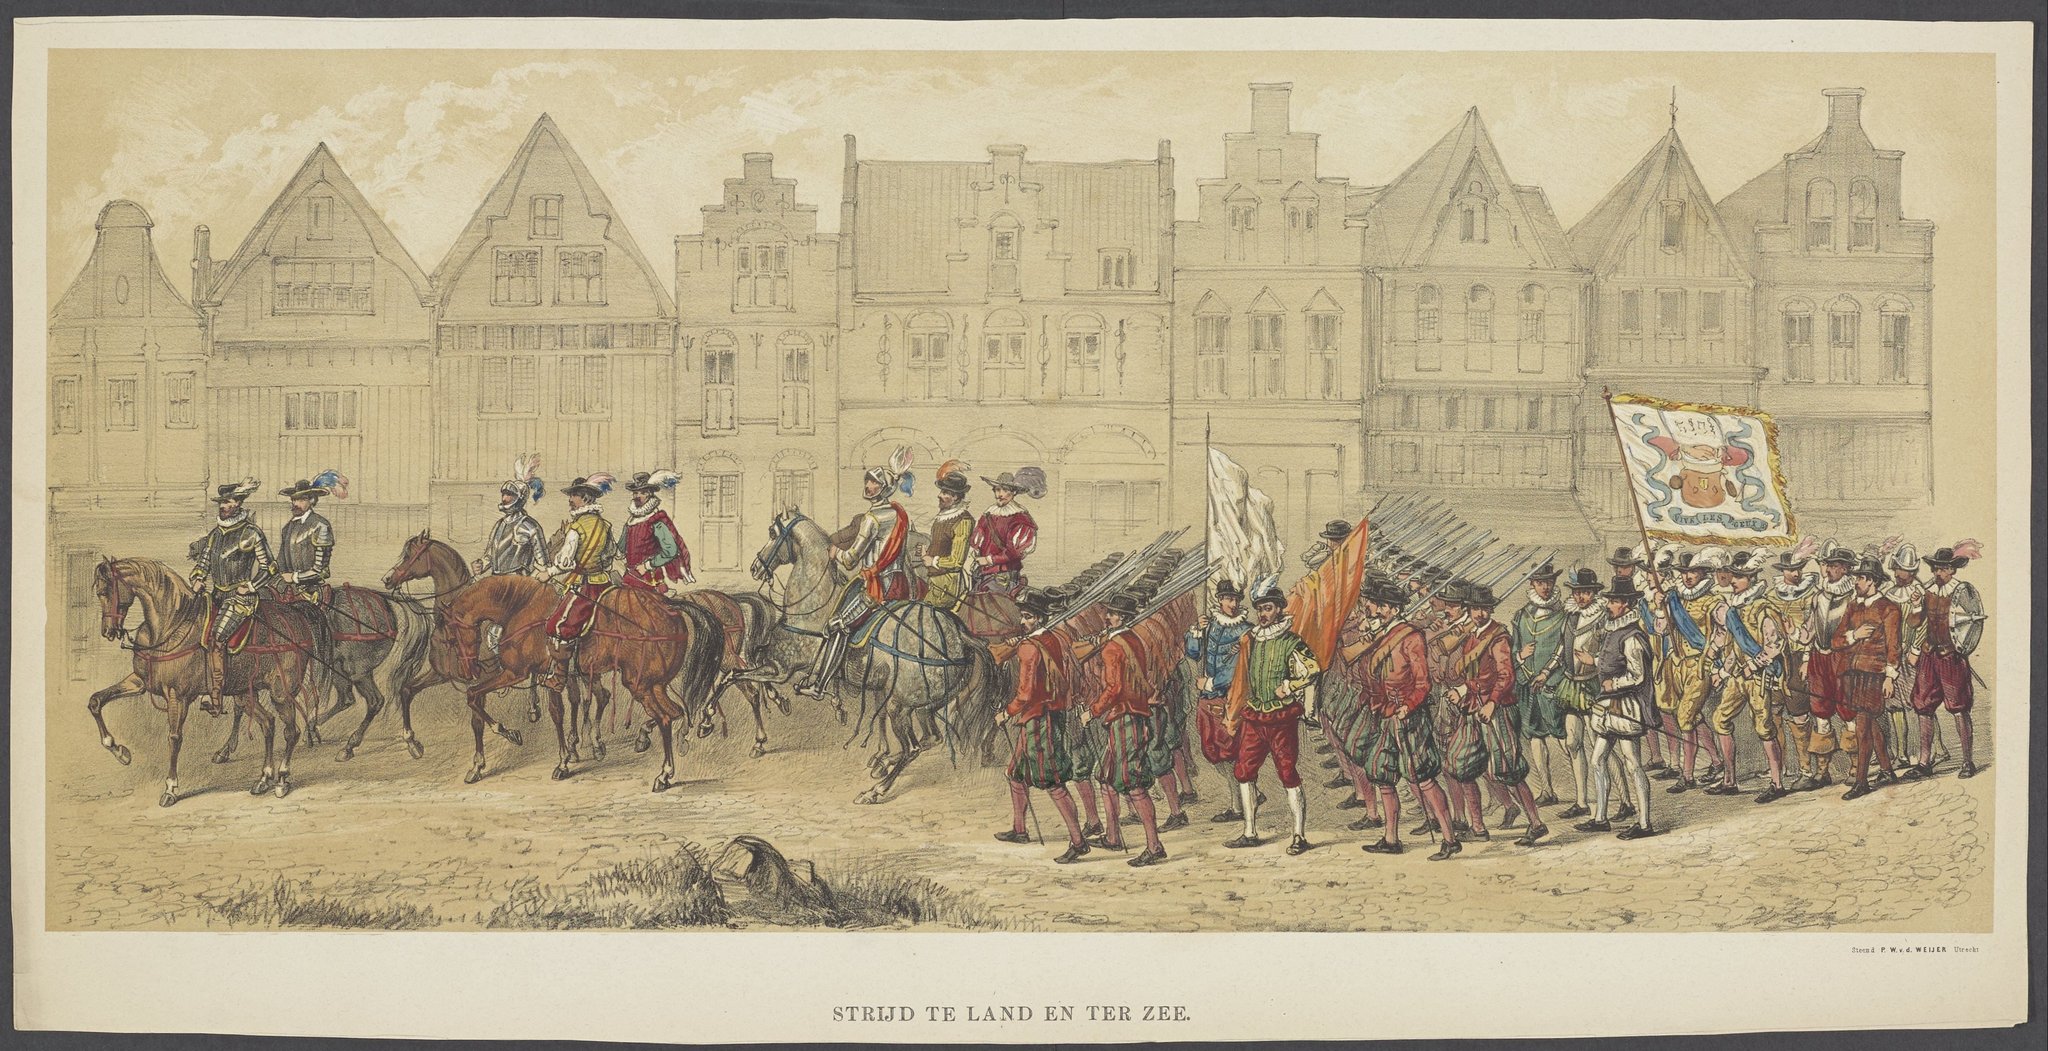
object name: print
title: Strijd te land en ter zee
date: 1856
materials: paper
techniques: hand coloring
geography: netherlands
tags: delft, william i (prince of orange), students' pageant, costumes used in pageants, utrecht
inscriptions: collector's mark: Lugt 2228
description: Ruiters en voetvolk van het Staatse leger. Onderdeel van een groep van zes platen met verklaring van de historische optocht in maskerade opgevoerd door de studenten van de Utrechtse Hogeschool op 17 juni 1856 ter gelegenheid van de viering van haar 220-jarige bestaan.